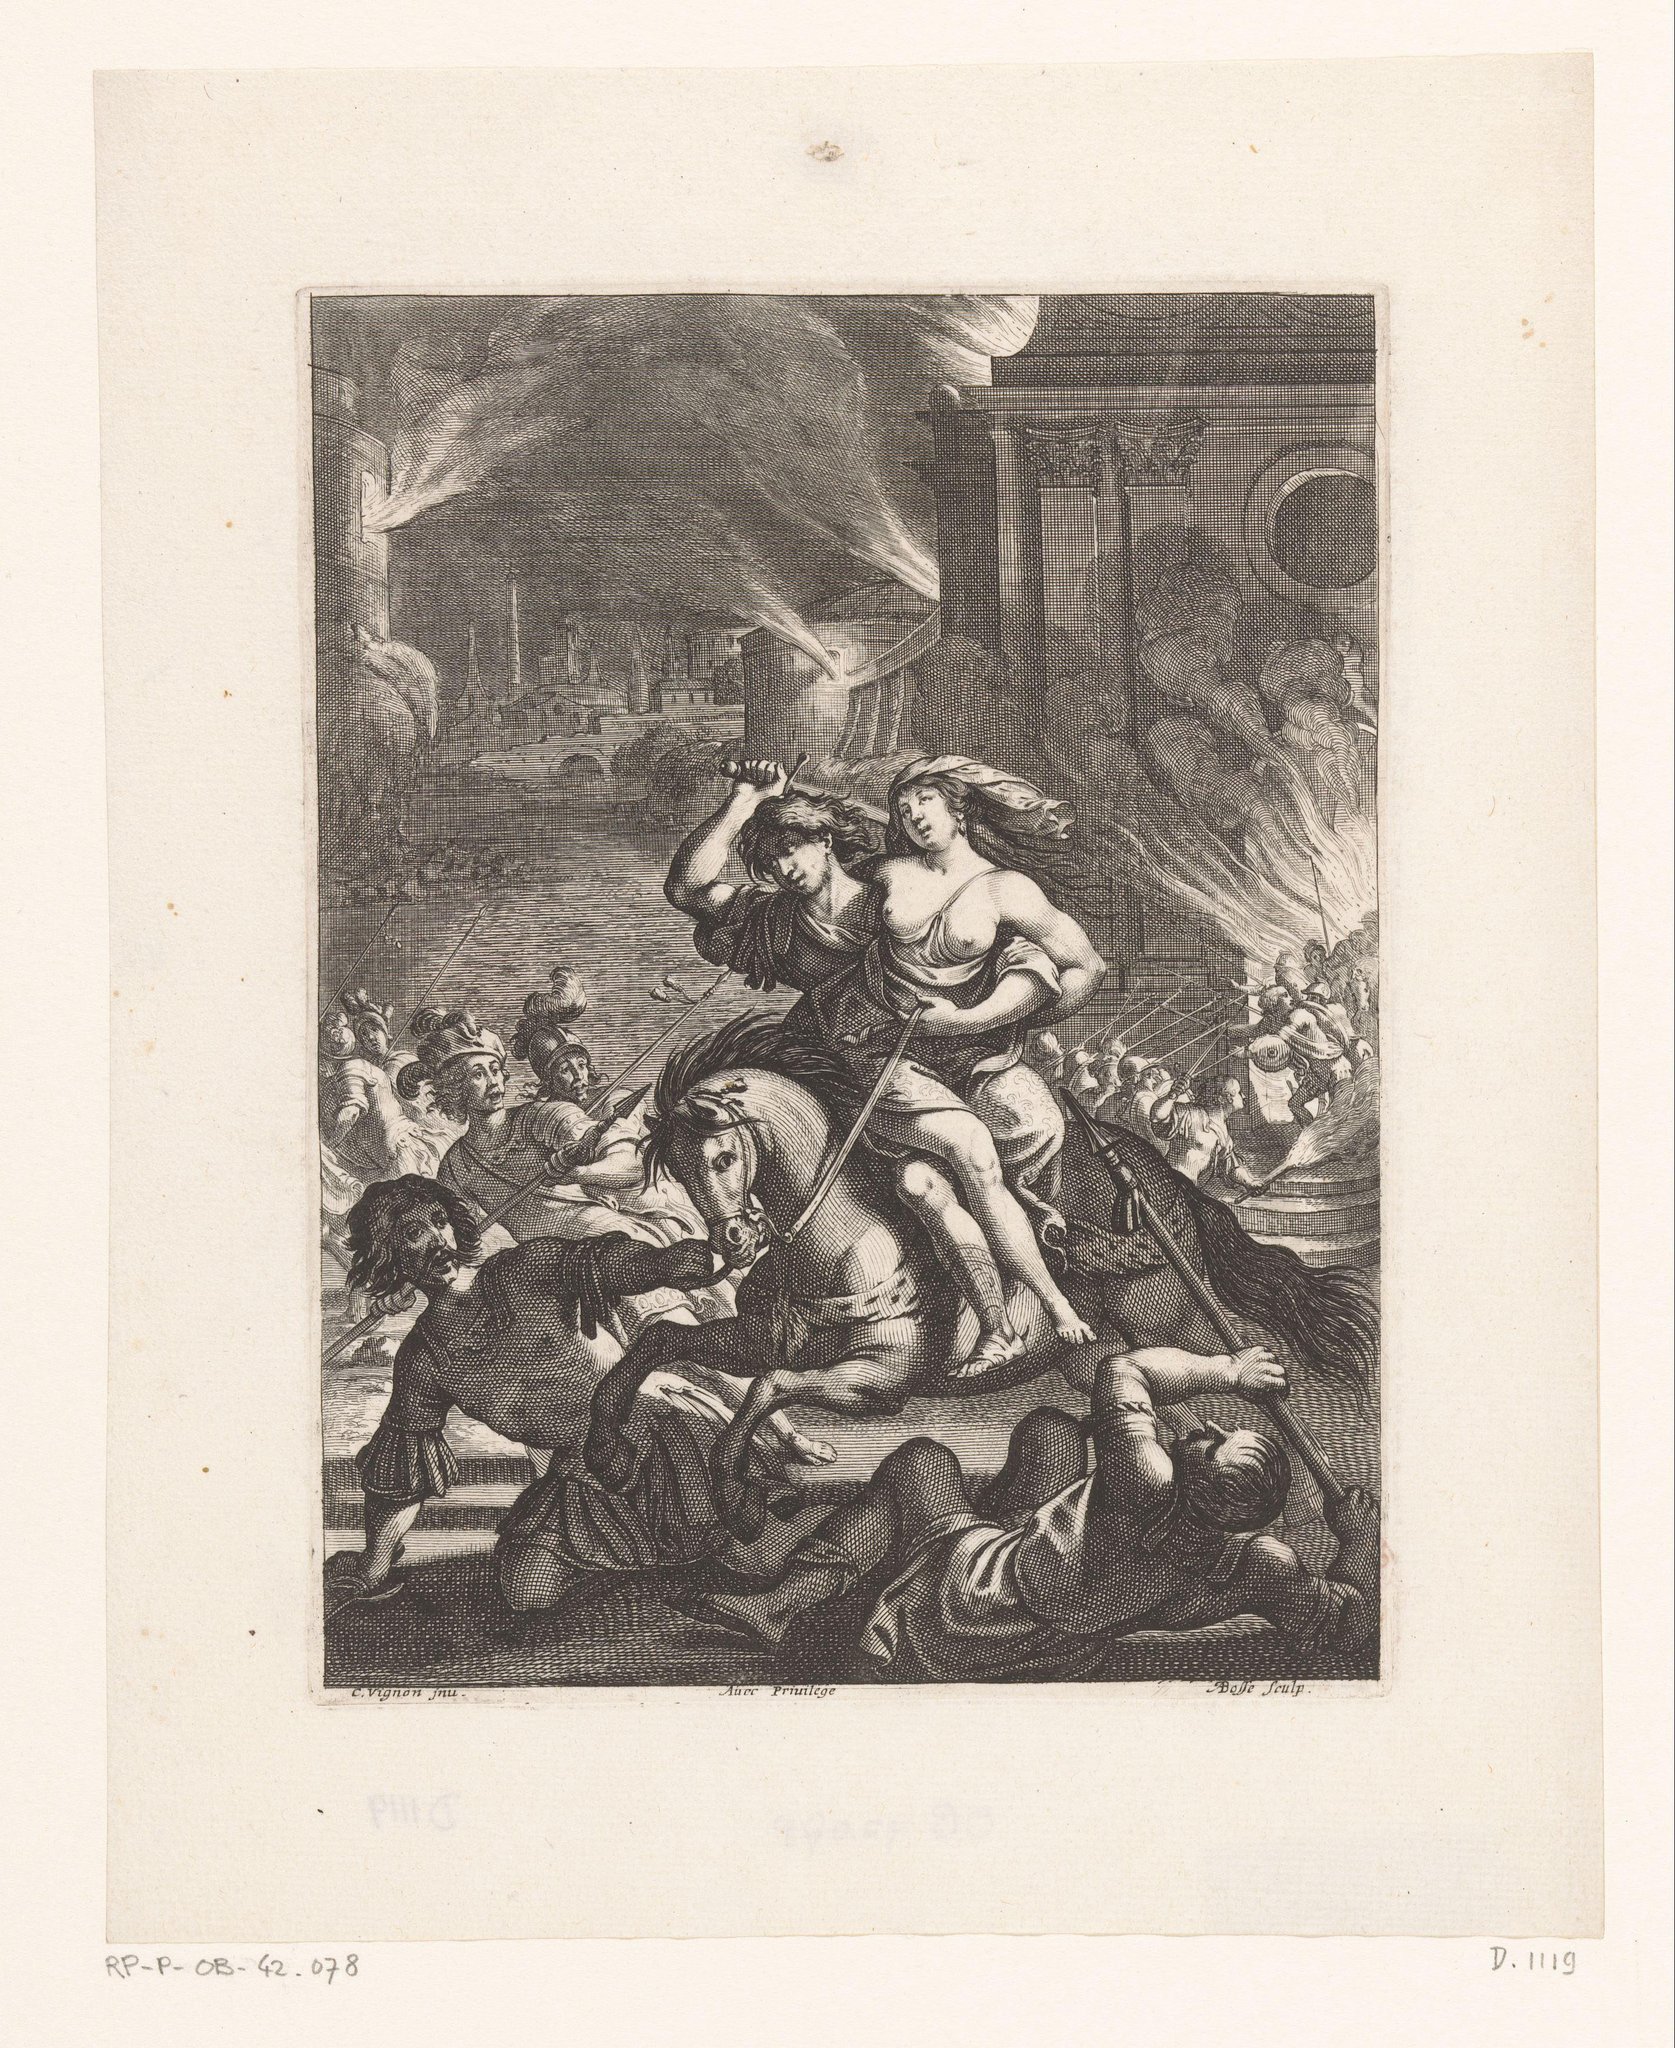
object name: book illustration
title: Melinte redt Ariane te paard uit het door Néron in brand gestoken huis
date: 1639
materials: paper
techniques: engraving, etching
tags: on fire, ablaze, rescue from fire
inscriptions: collector's mark: Lugt 240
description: Prent uit: Desmarets de Saint-Sorlin, Jean. L'Ariane. Parijs: Guillemot, Matthieu, 1639.